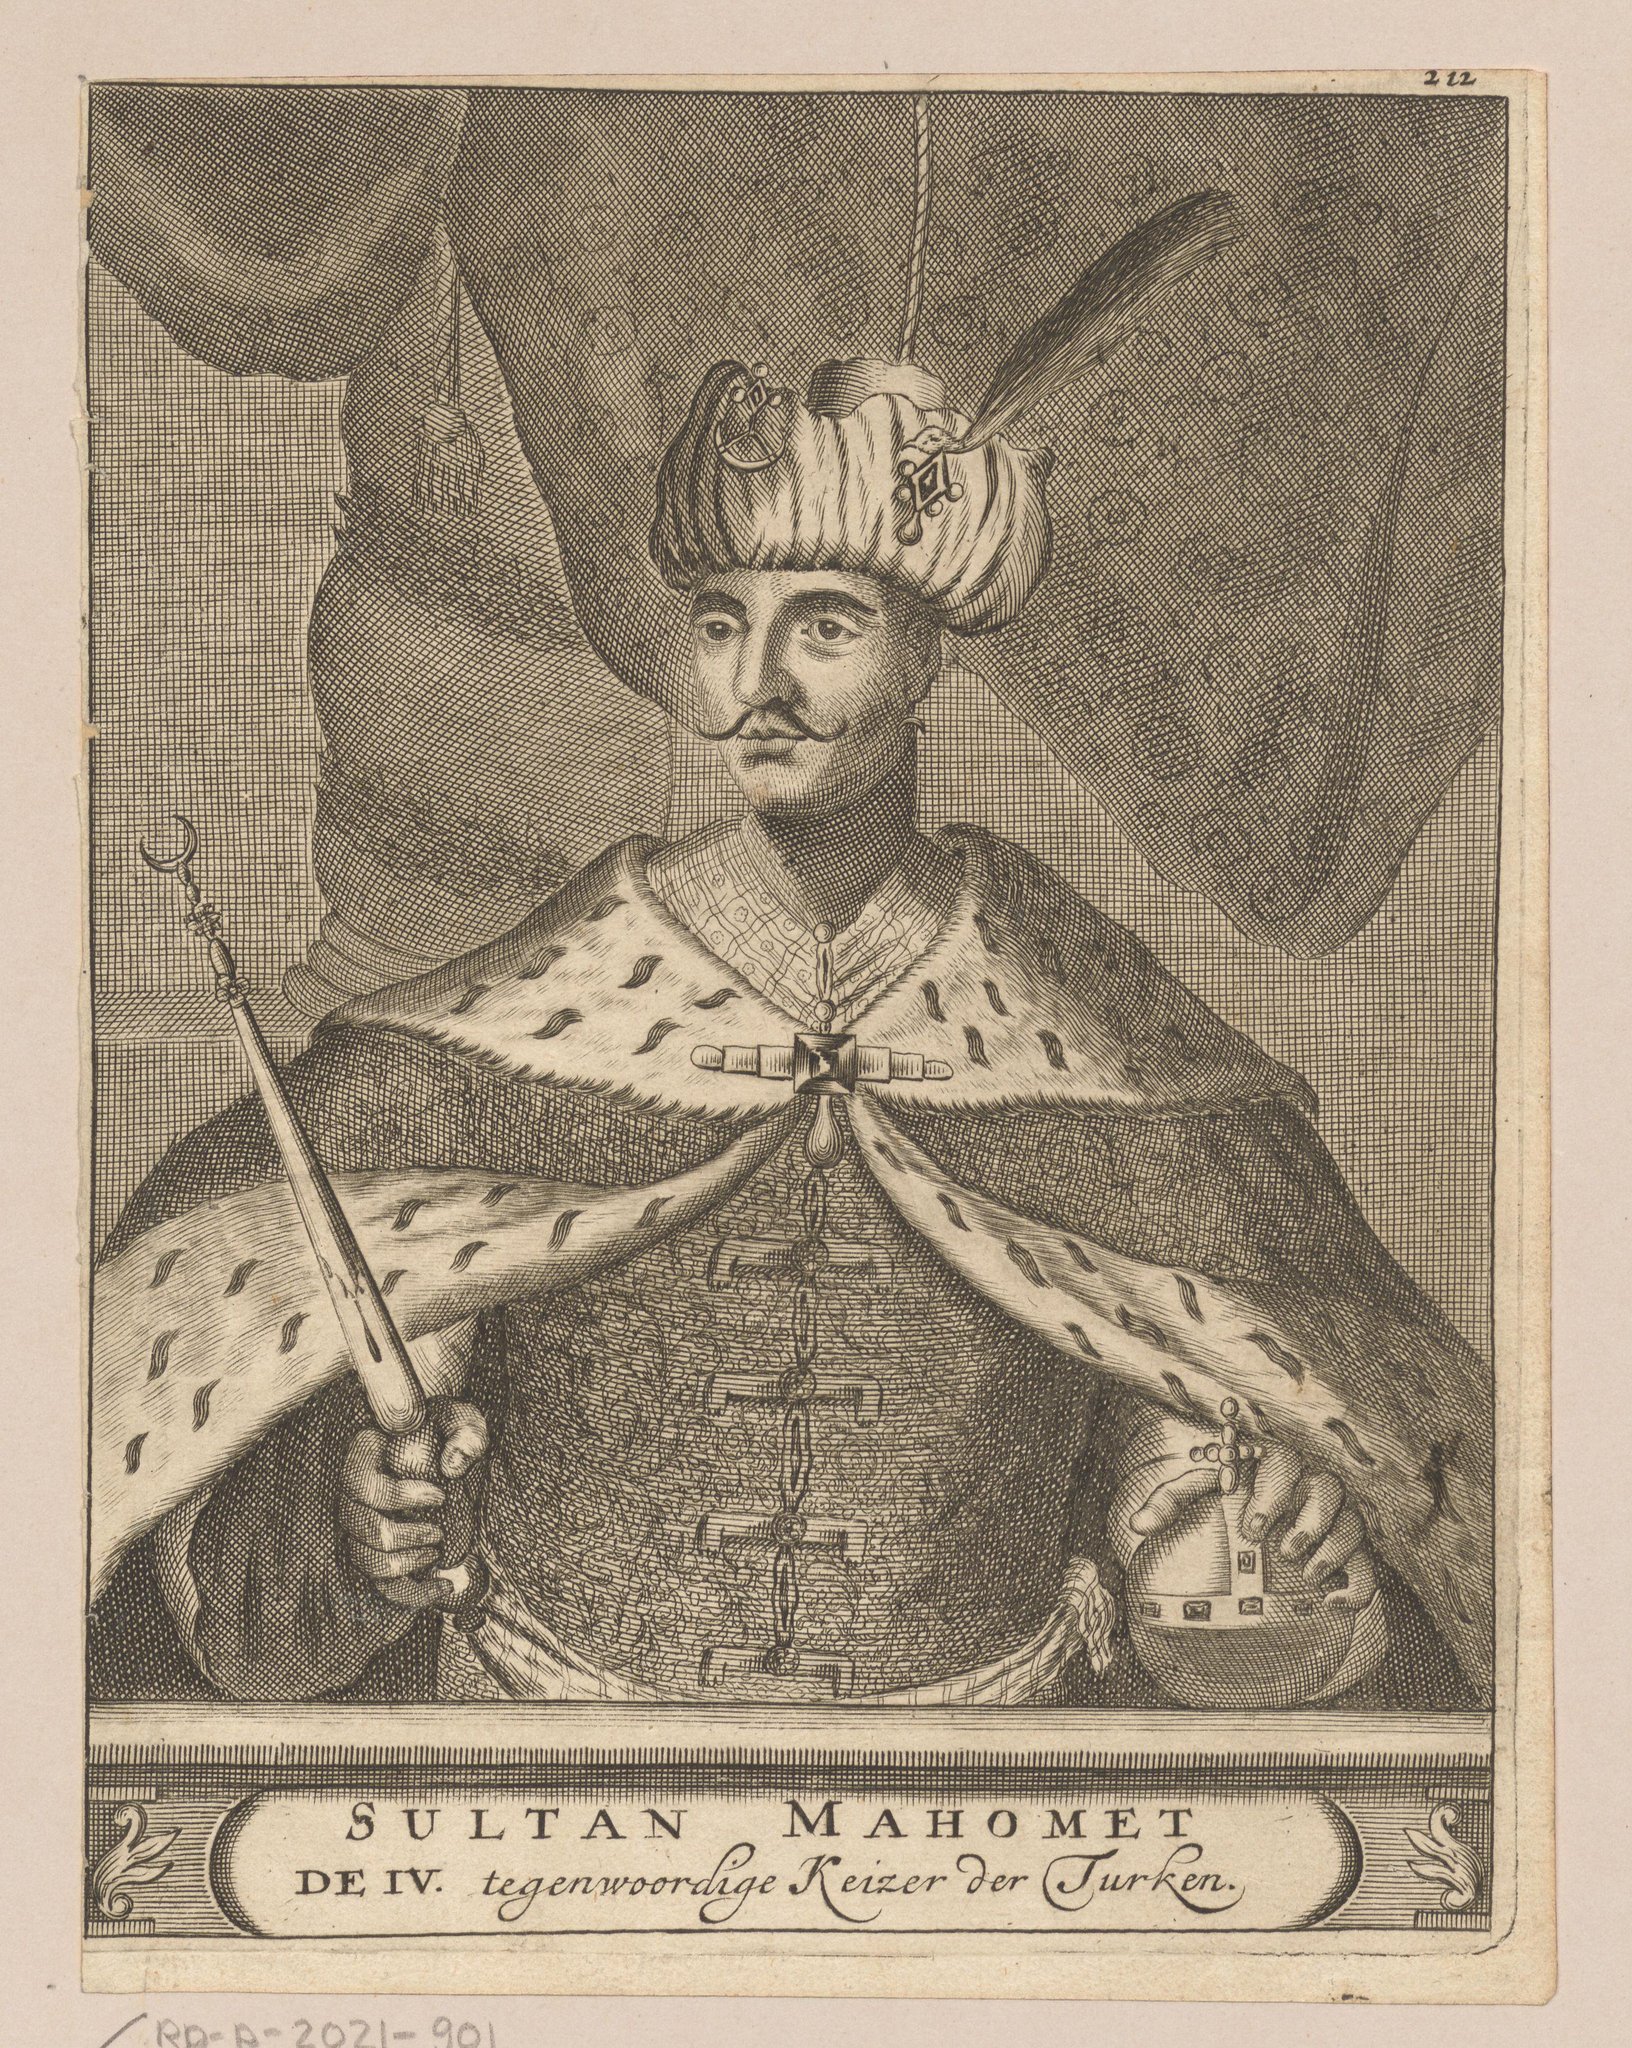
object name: print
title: Portret van Mehmet IV, sultan van het Ottomaanse Rijk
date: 1670-1770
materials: paper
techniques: engraving, etching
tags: historical persons, head-gear: turban, ruler, sovereign